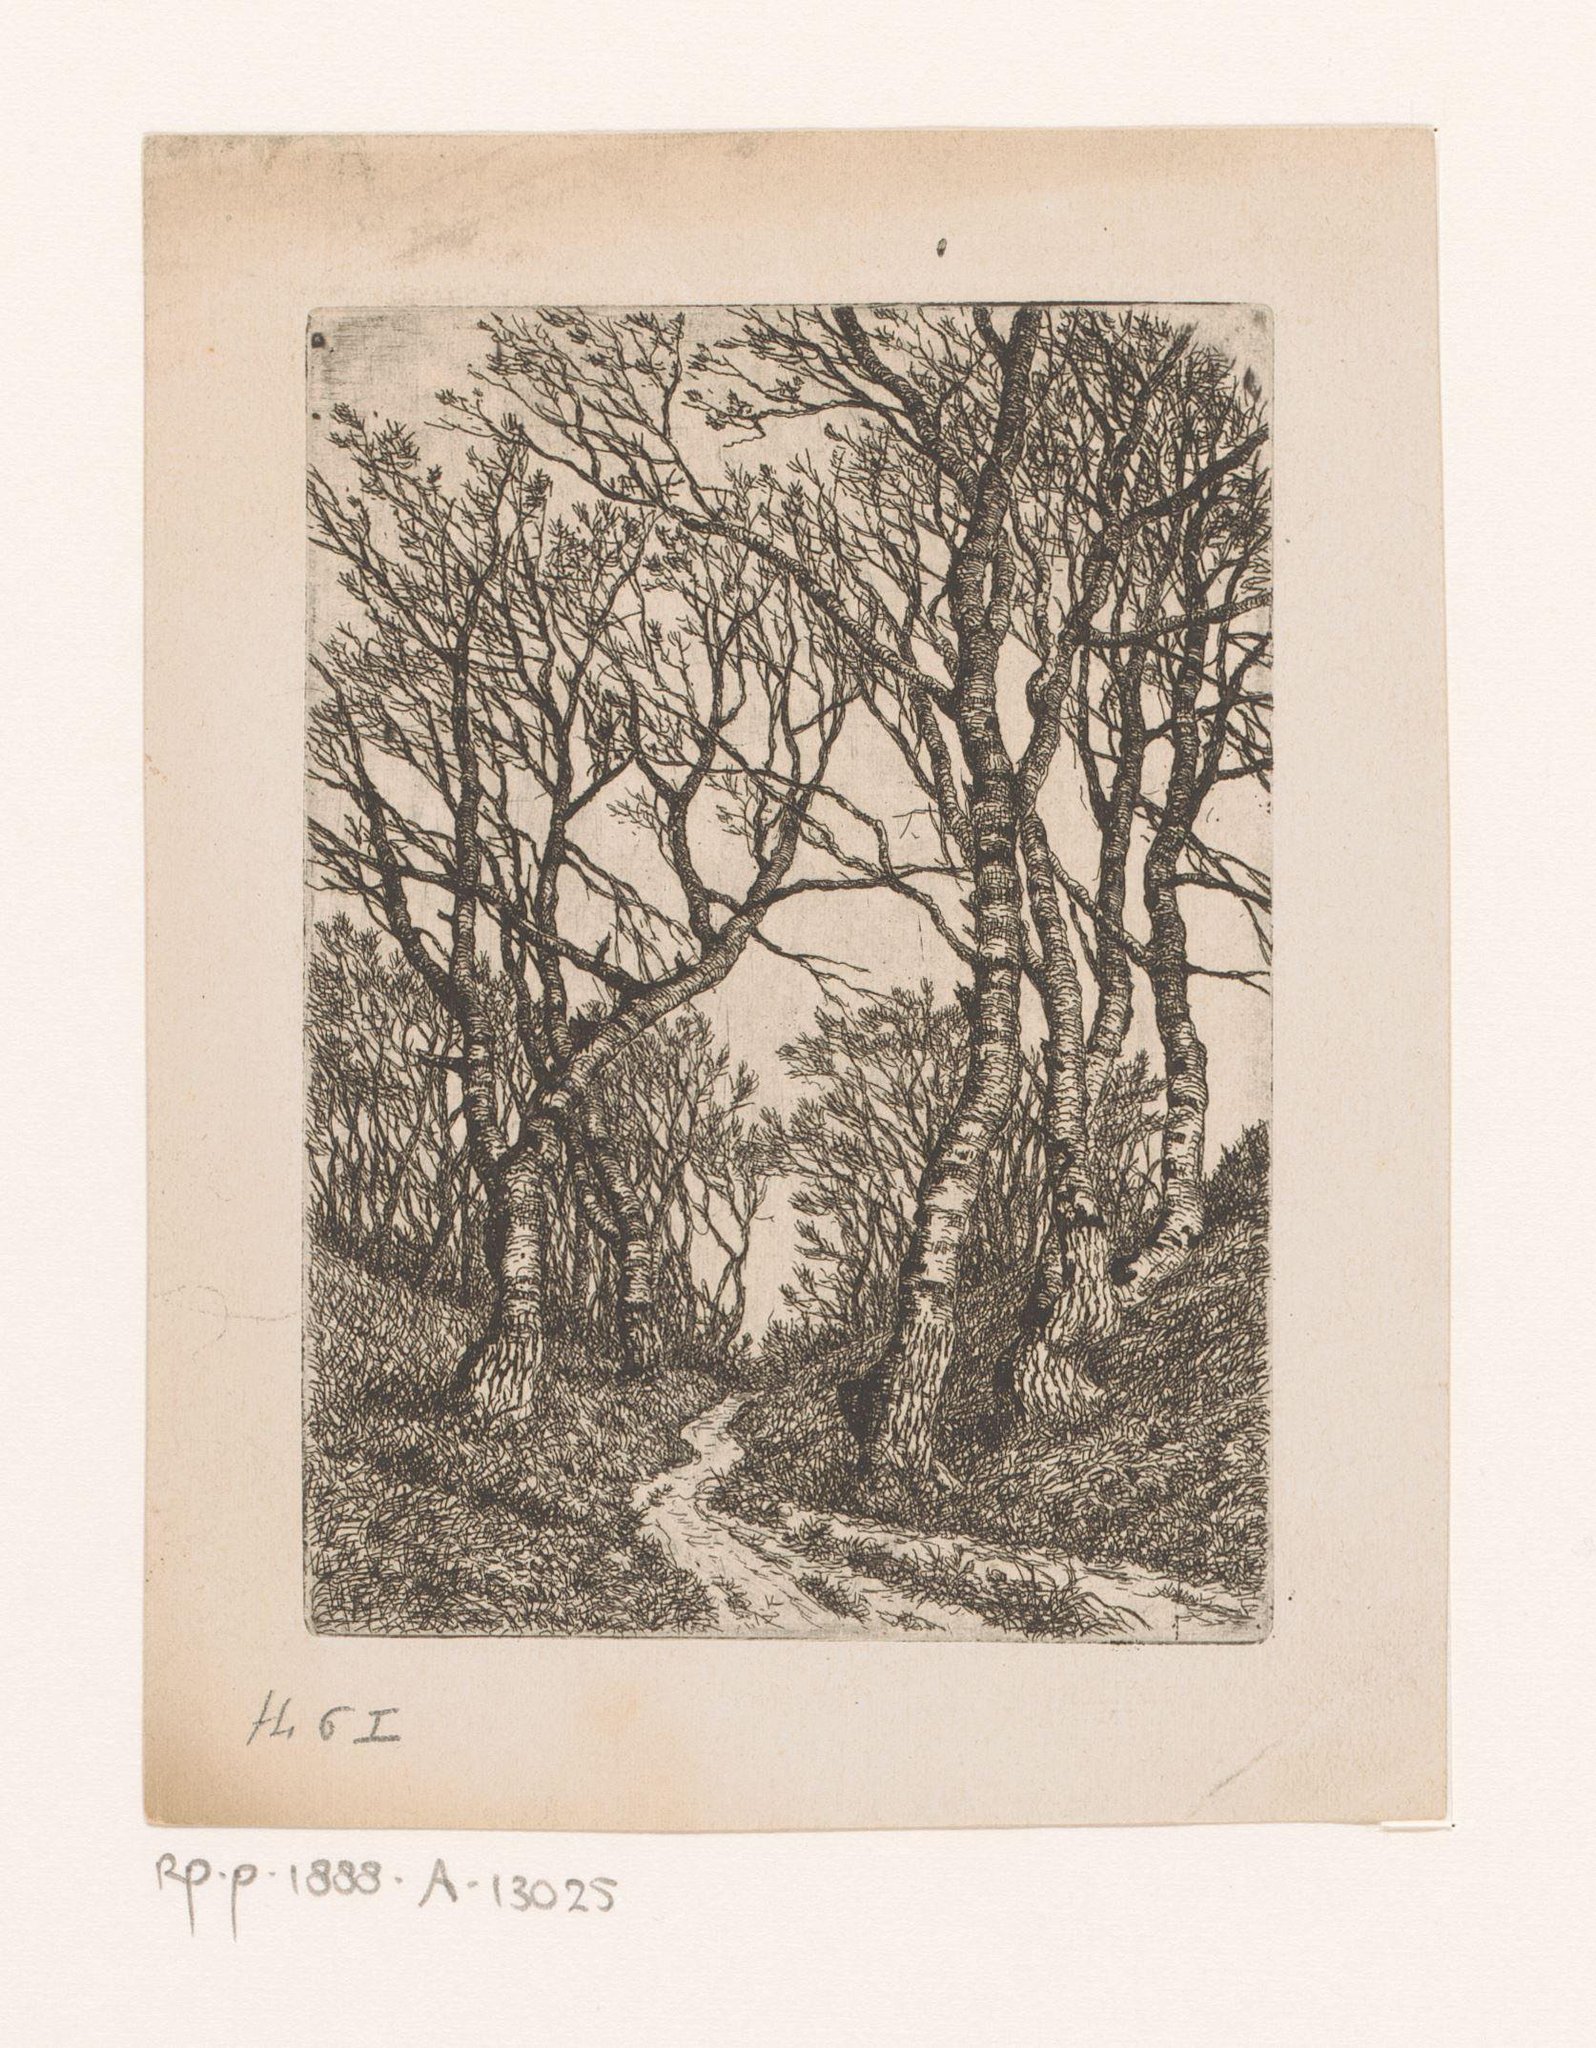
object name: print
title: Bosrand met een pad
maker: jean pierre françois lamorinière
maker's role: print maker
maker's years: 1828-1911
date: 1838-1888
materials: paper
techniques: etching, intaglio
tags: fringe, edge of the wood, forest path or lane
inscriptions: collector's mark: Lugt 2228